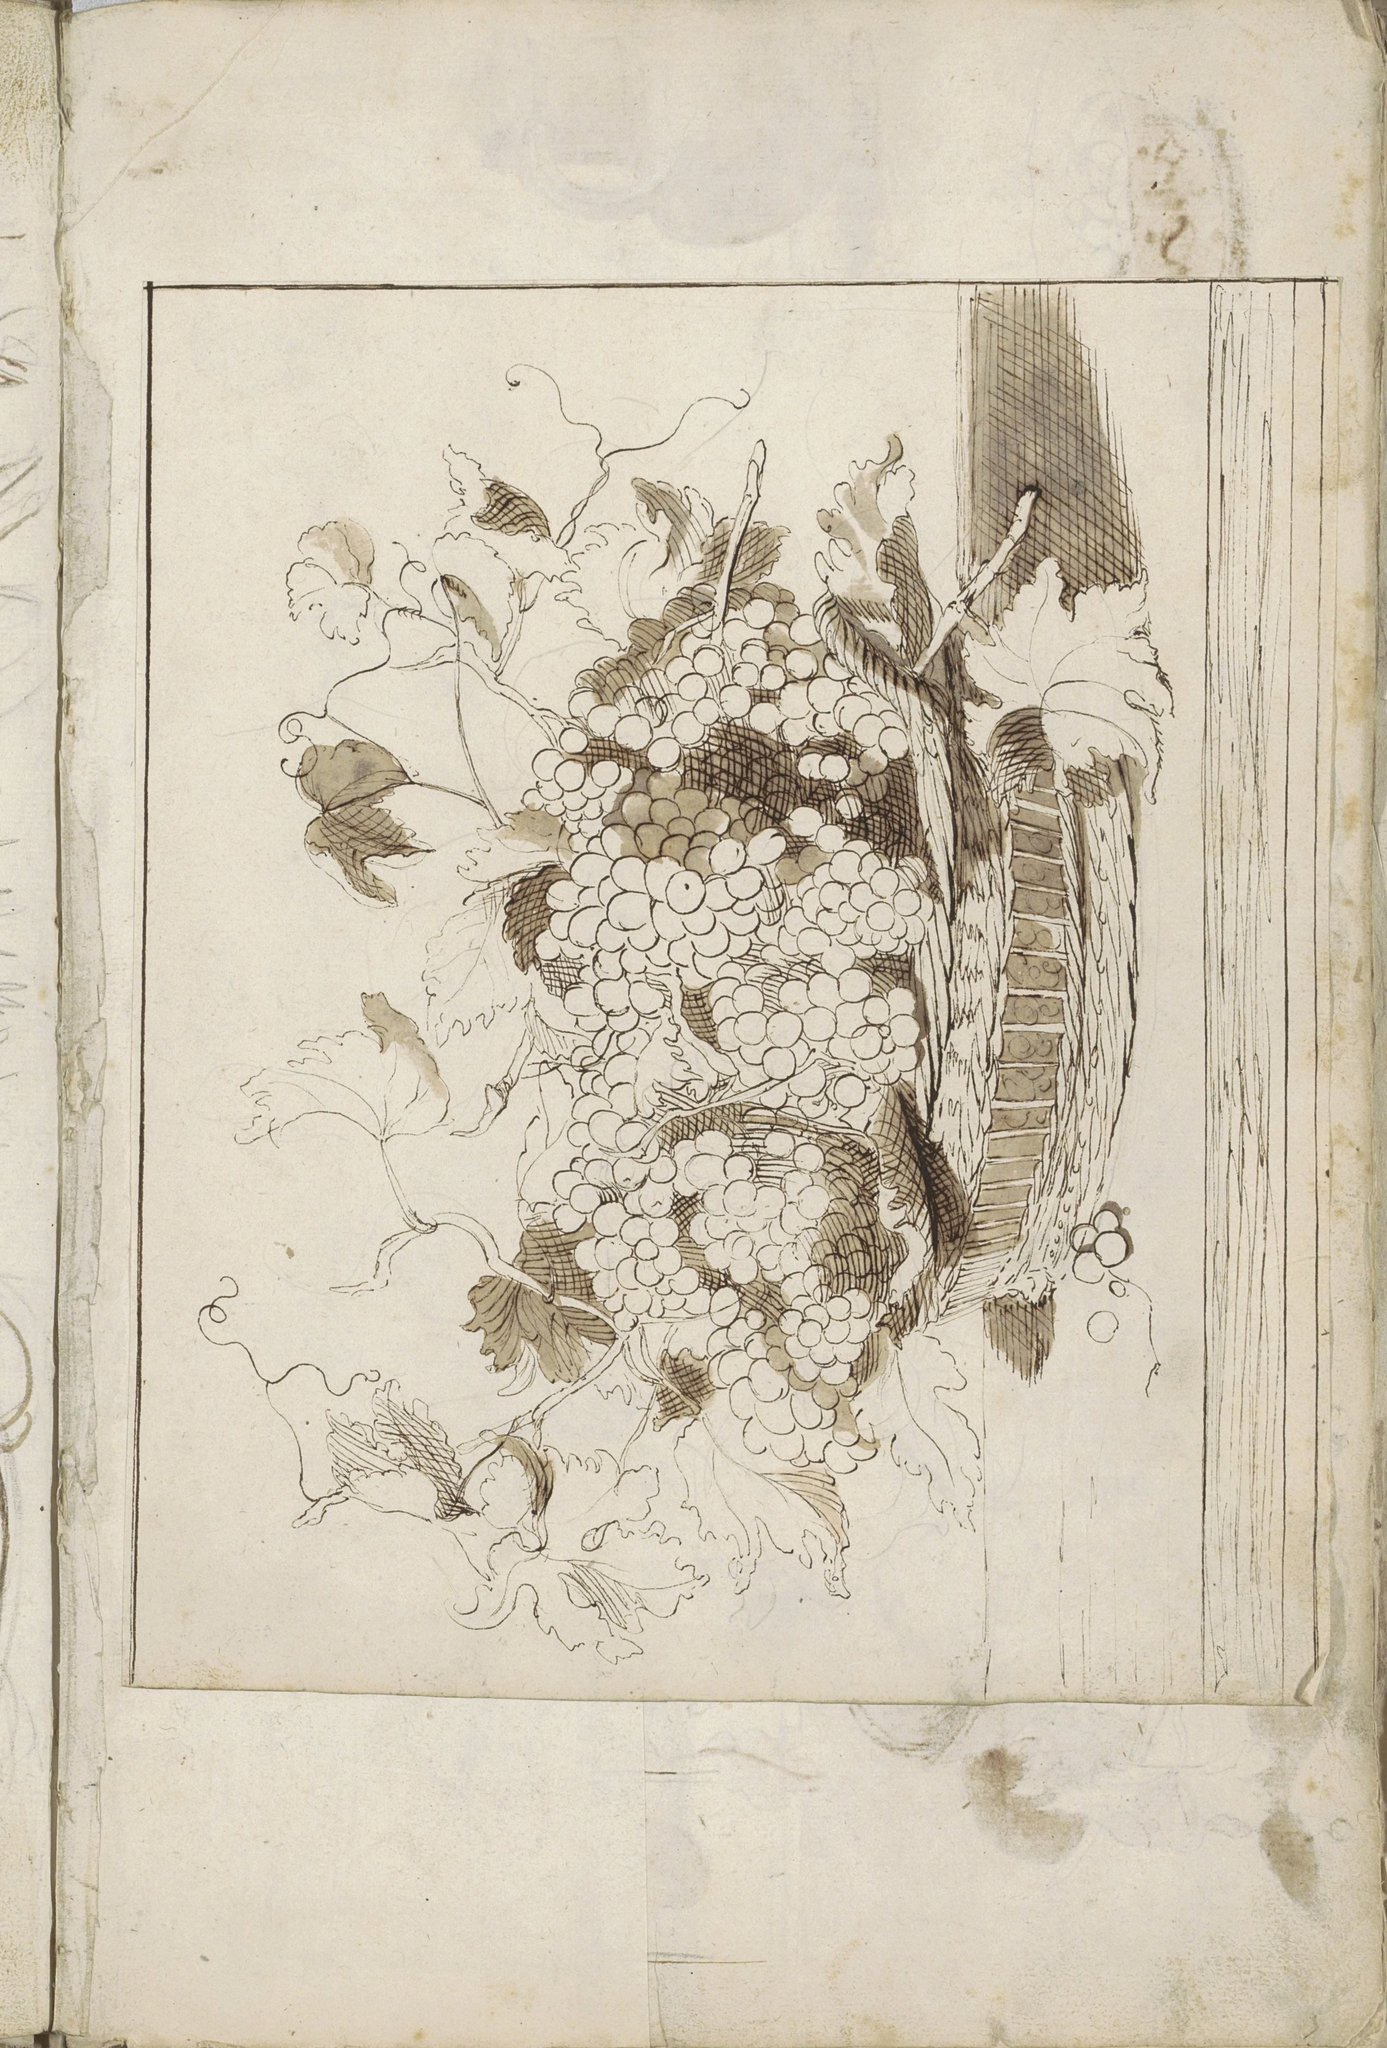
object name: sketchbook leaf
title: Stilleven met druiven in een rieten mand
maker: paul de vos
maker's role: draughtsman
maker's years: 1595-1678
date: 1605-1678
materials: ink, paper, pencil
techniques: brush, pen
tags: container made of plant material other than wood: basket, still life of related objects, bunch of grapes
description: Tekening in een kader. Blad 3 recto uit een schetsboek met 15 bladen.